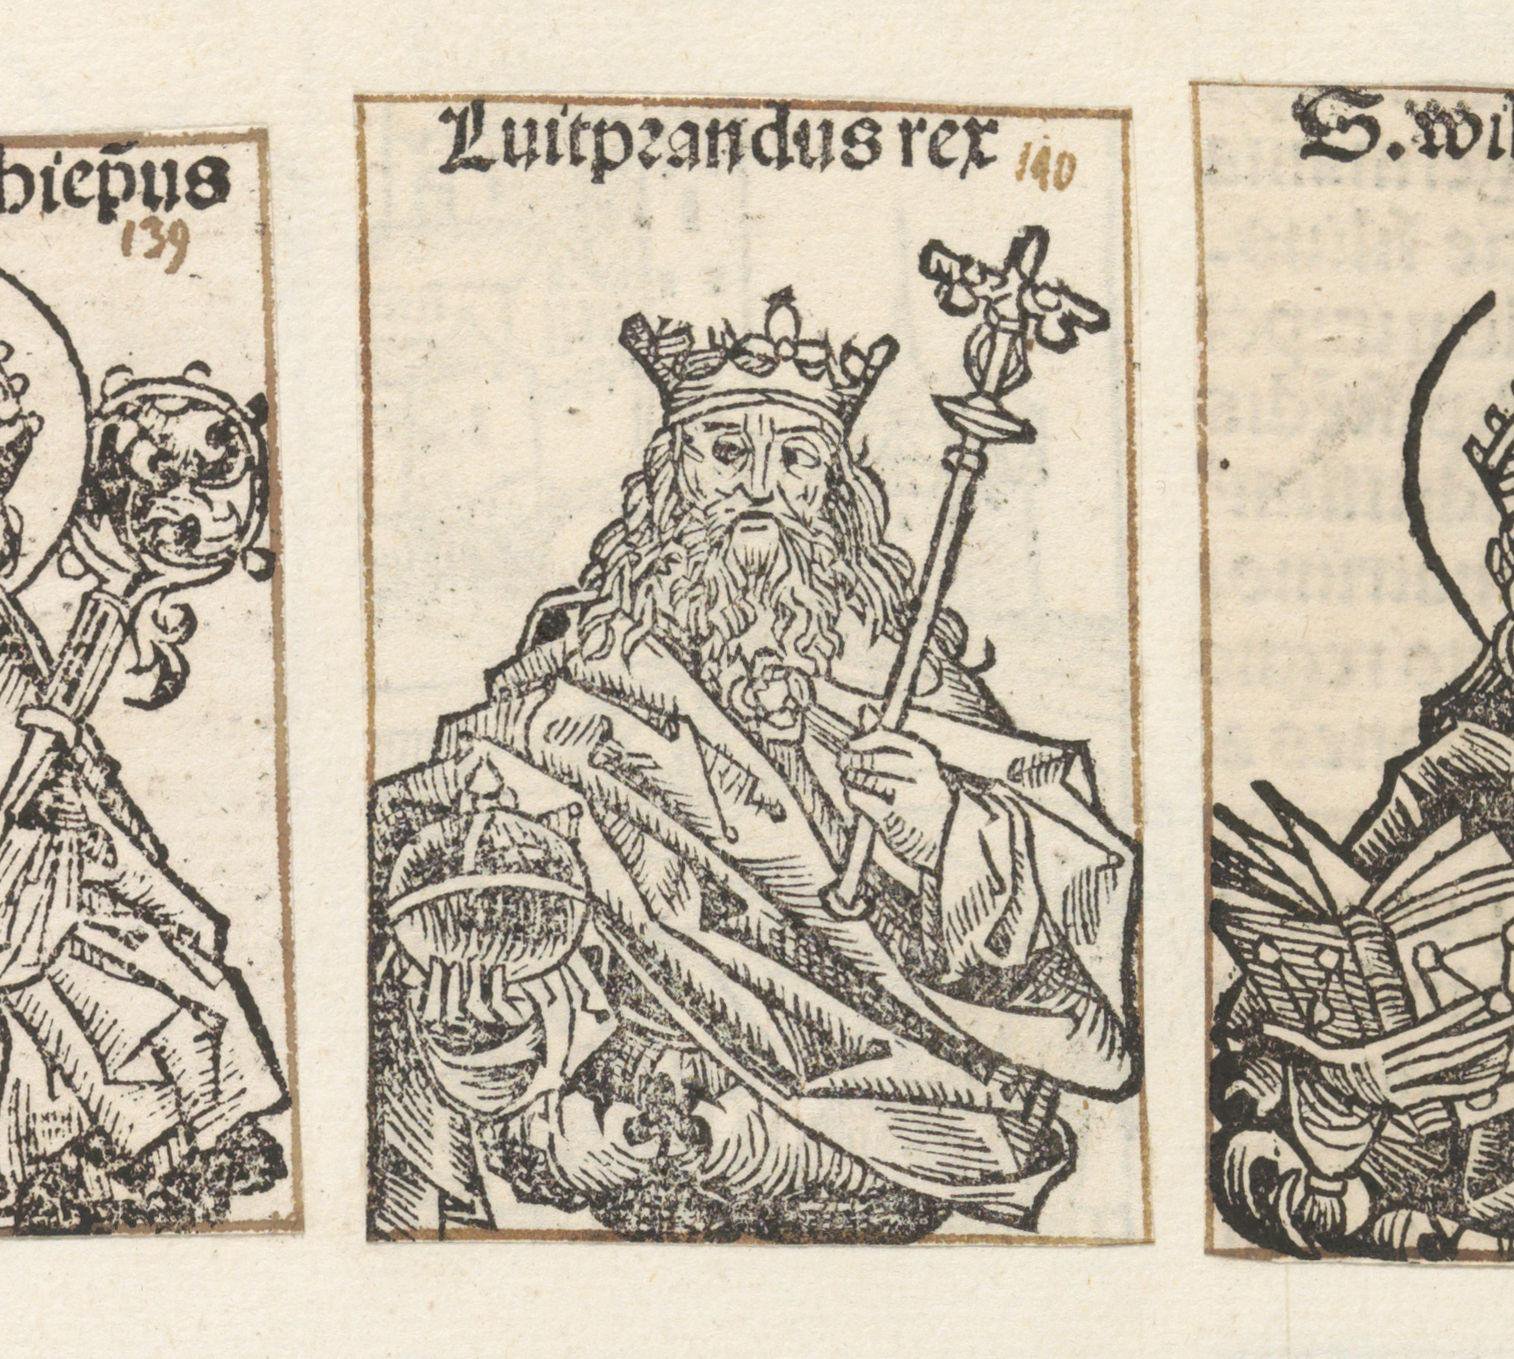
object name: album leaf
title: Koning Liutprand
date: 1493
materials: paper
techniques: letterpress printing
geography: nuremberg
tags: king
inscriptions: inscription: ‘140’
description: De houtsnede wordt herhaaldelijk gebruikt als boekillustratie in de Liber Chronicarum (of Neurenbergkroniek) van Hartmann Schedel, verschenen in het Latijn en Duits in 1493. Zie de Latijnse uitgave, folio 162v.